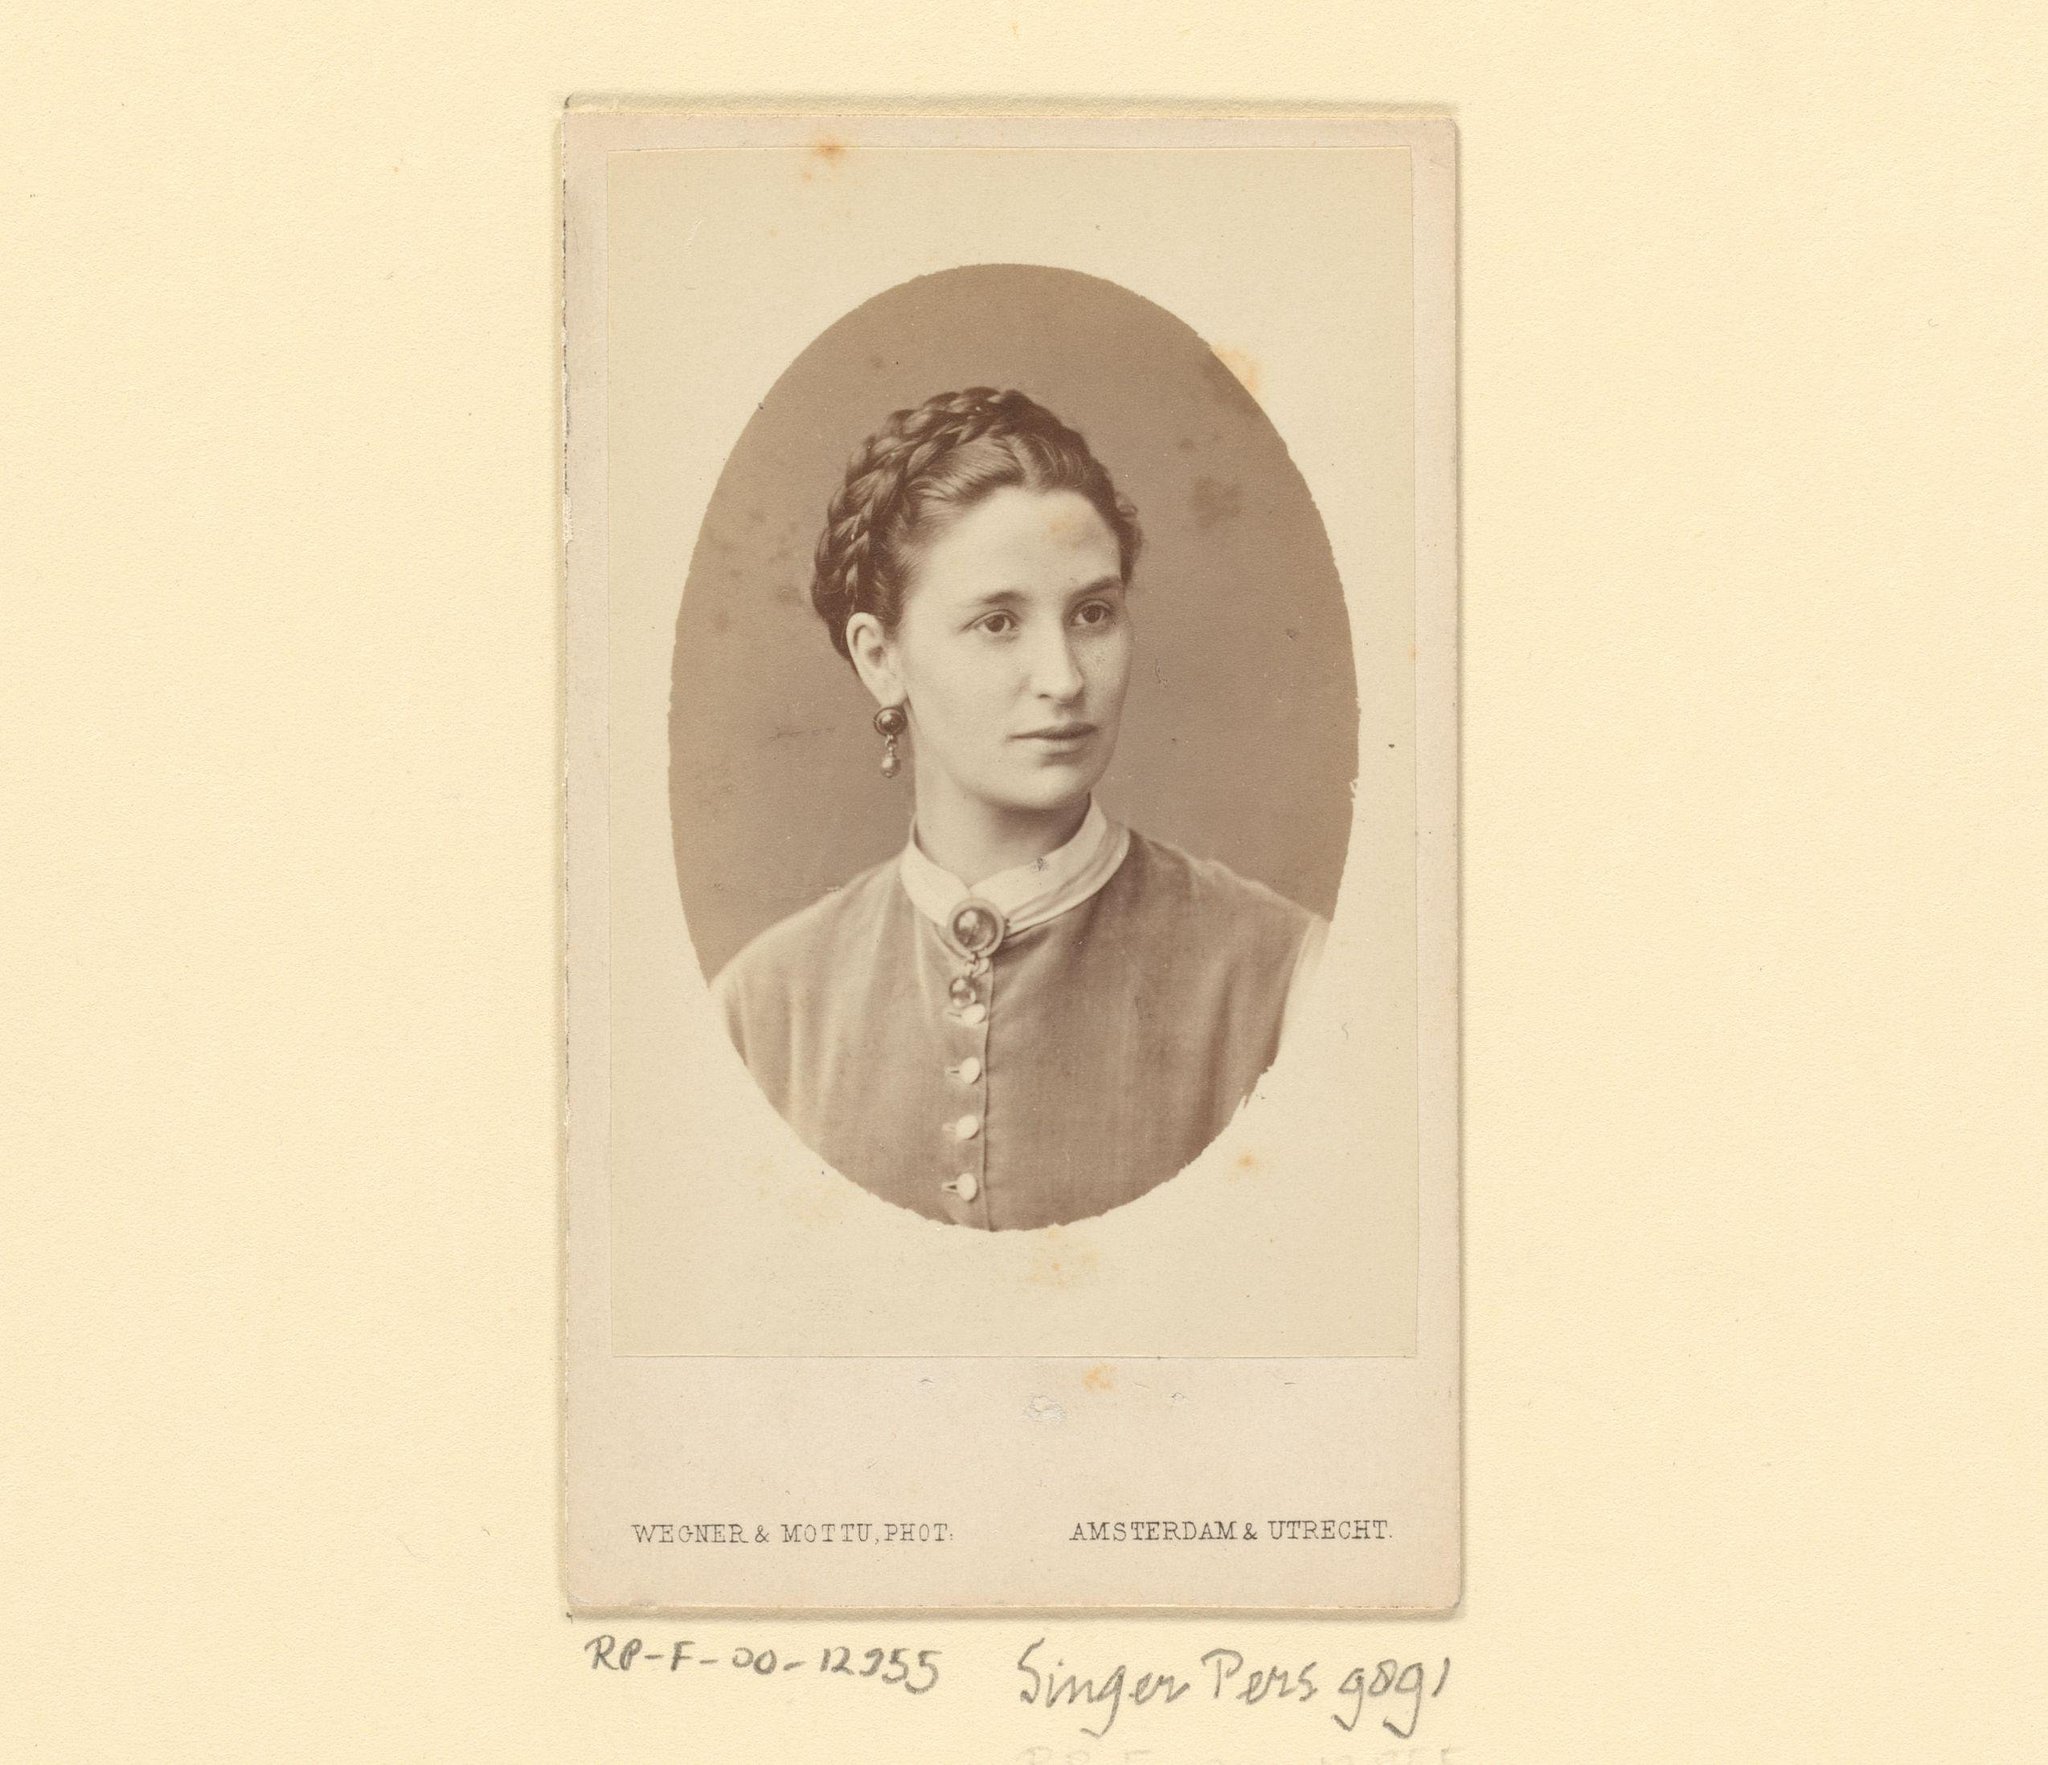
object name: carte de visite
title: Portret van Charlotte Frohn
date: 1870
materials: cardboard, paper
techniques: albumen print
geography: amsterdam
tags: historical persons - bb - woman, portrait of actor, actress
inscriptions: inscription: ‘Photogr. Atelier/ Wegner & Mottu (...) Utrecht’, inscription: ‘Charlotte Frohn,/ 1870./ Artiste van Darmstadt,/ munt uit in/ 't treurspel.’